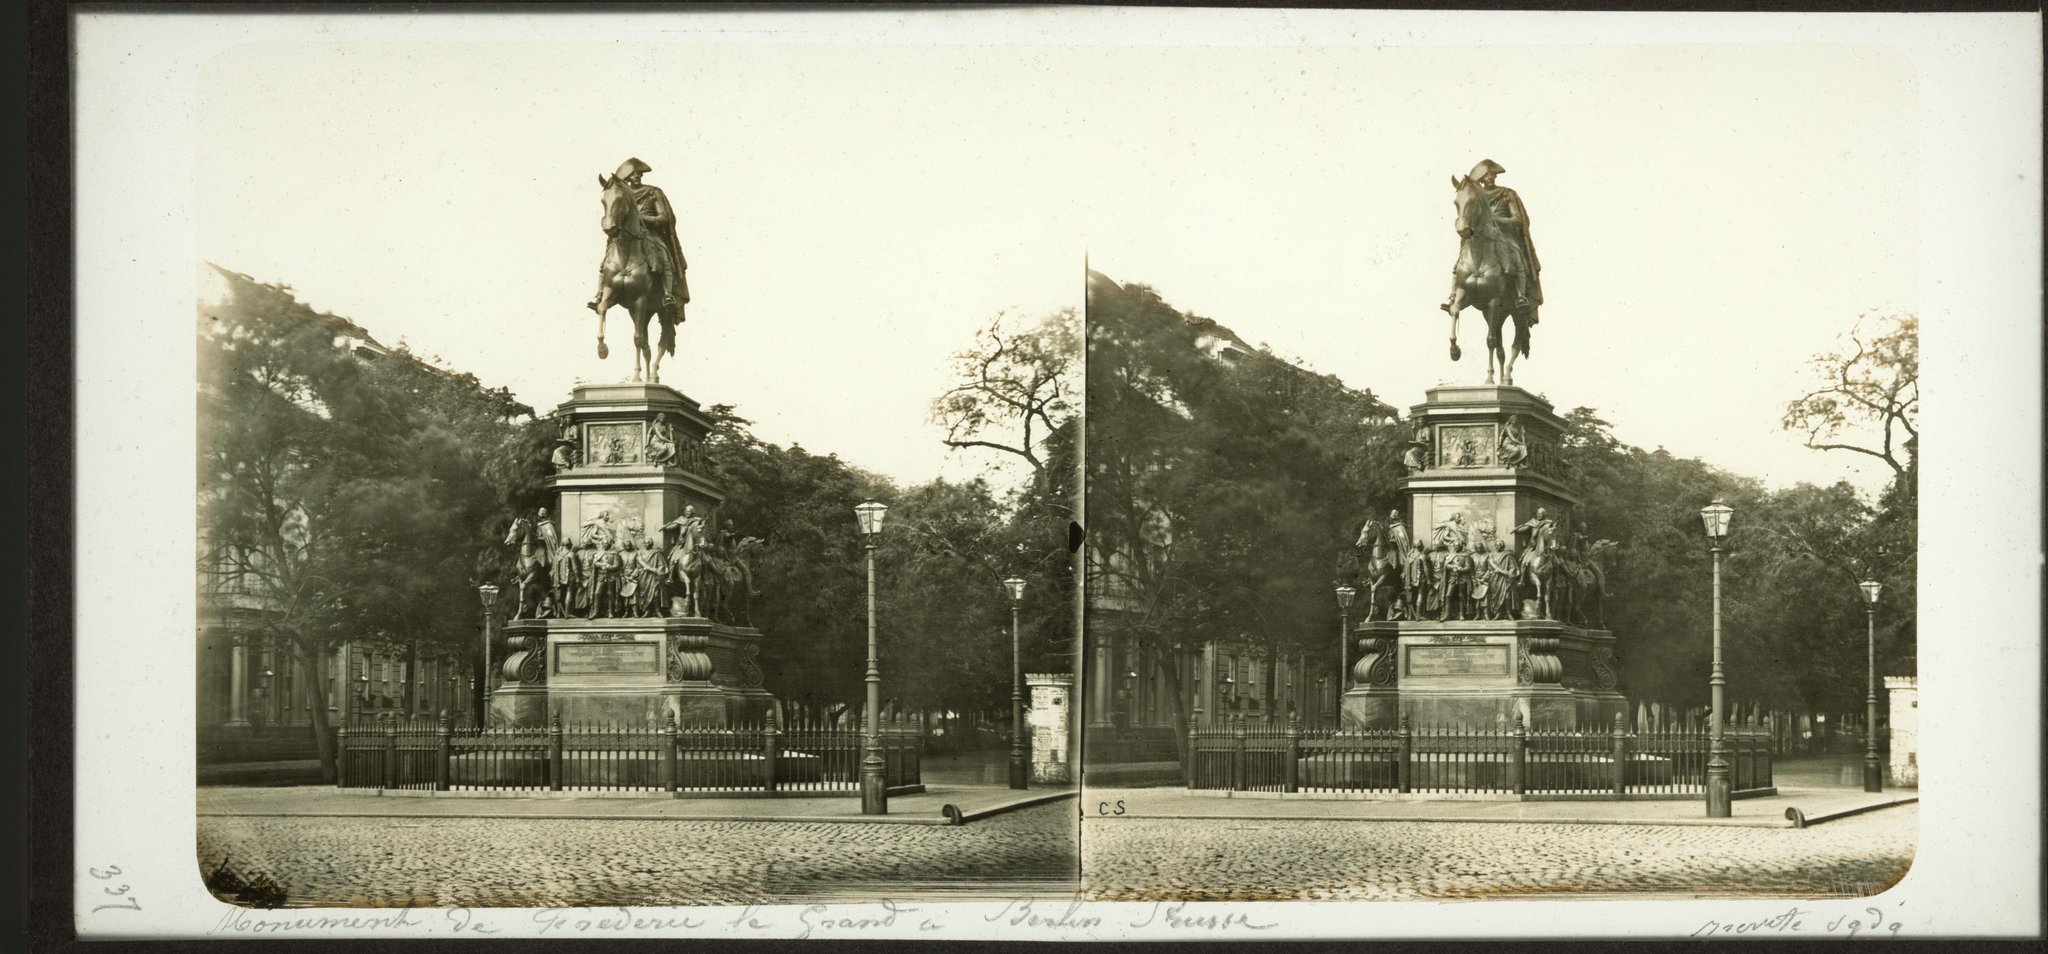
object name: photograph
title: Standbeeld van Frederik de Grote in Berlijn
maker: ferrier père-fils et soulier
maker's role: publisher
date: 1855-1865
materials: glass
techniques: photography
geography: berlin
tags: berlin, frederick ii (king of prussia), equestrian statue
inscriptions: title: ‘337 Monument de Frederic le Grand à Berlin (Prusse)’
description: Ruiterstandbeeld van Frederik de Grote in Berlijn.